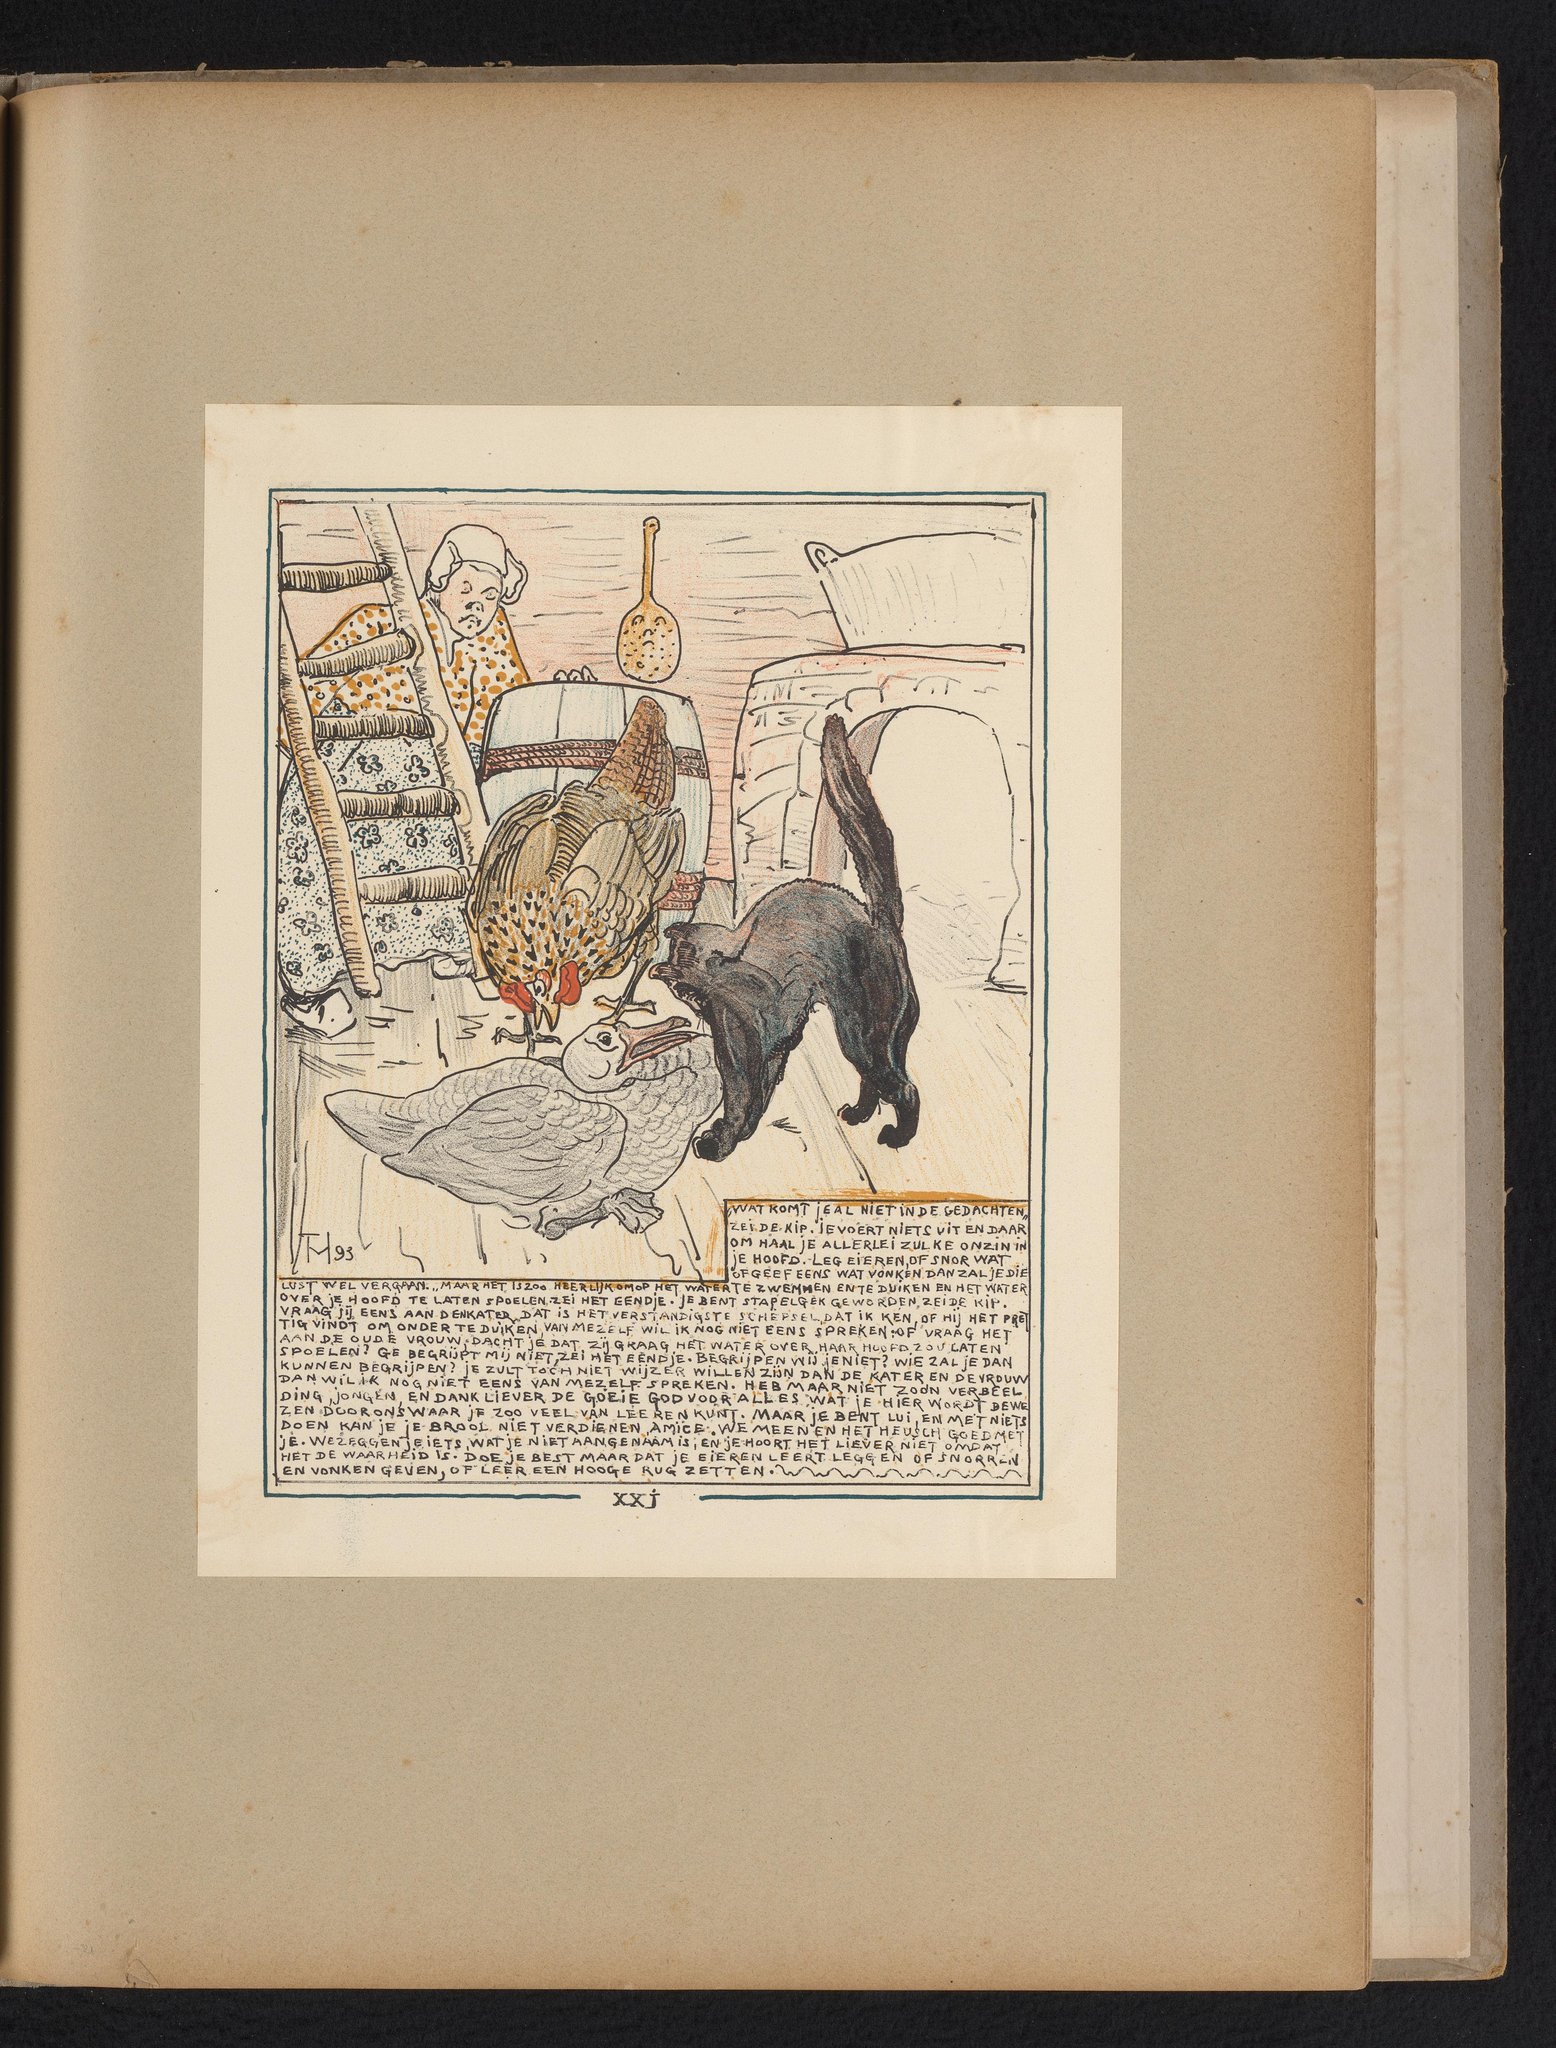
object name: print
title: Kat en kip met het zwanenjong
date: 1893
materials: paper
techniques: lithograph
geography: the hague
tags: cat, fowl (cock, hen, chicken, etc.), water-birds: duck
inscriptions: date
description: Deze prent maakt deel uit van een album.